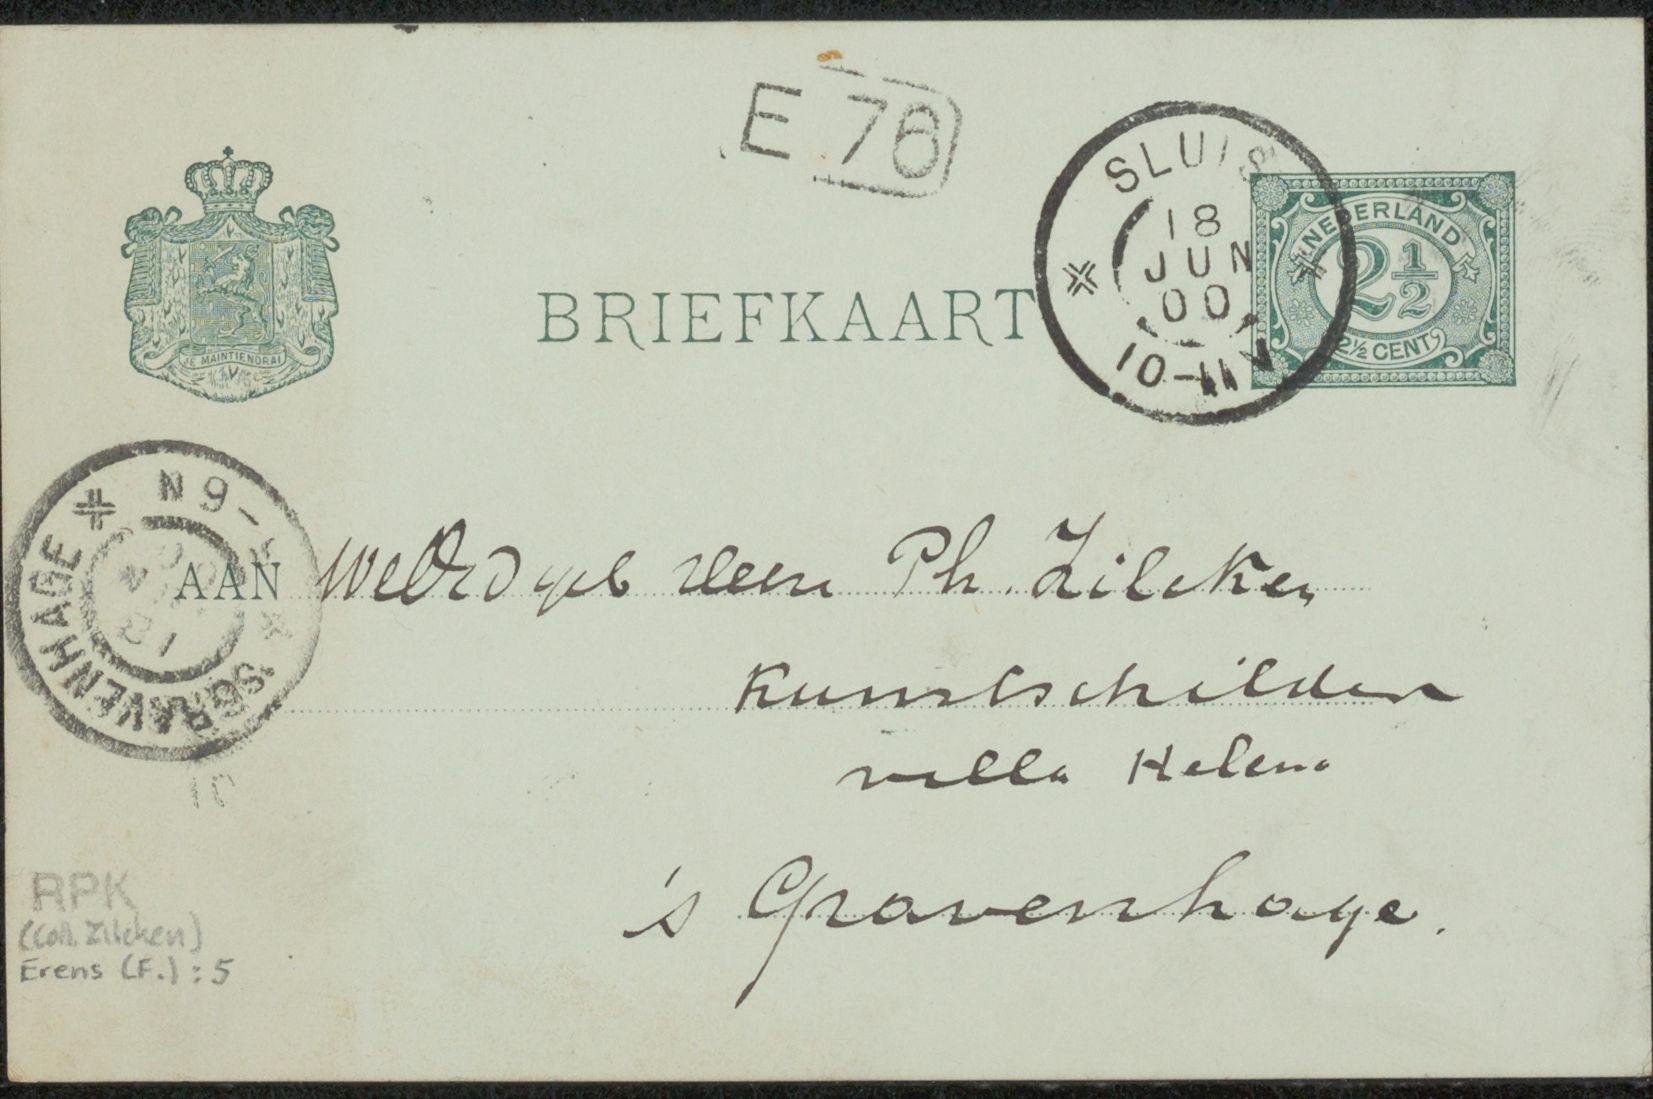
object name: postcard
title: Briefkaart aan Philip Zilcken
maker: frans erens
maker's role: criticus, prozaschrijver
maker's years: 1857-1935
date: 1900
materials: cardboard, ink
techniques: pen, writing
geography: sluis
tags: amsterdam, the hague, painter, print maker, draughtsman, isaac israels, philip zilcken, drawing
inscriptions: collector's mark: ‘RPK’